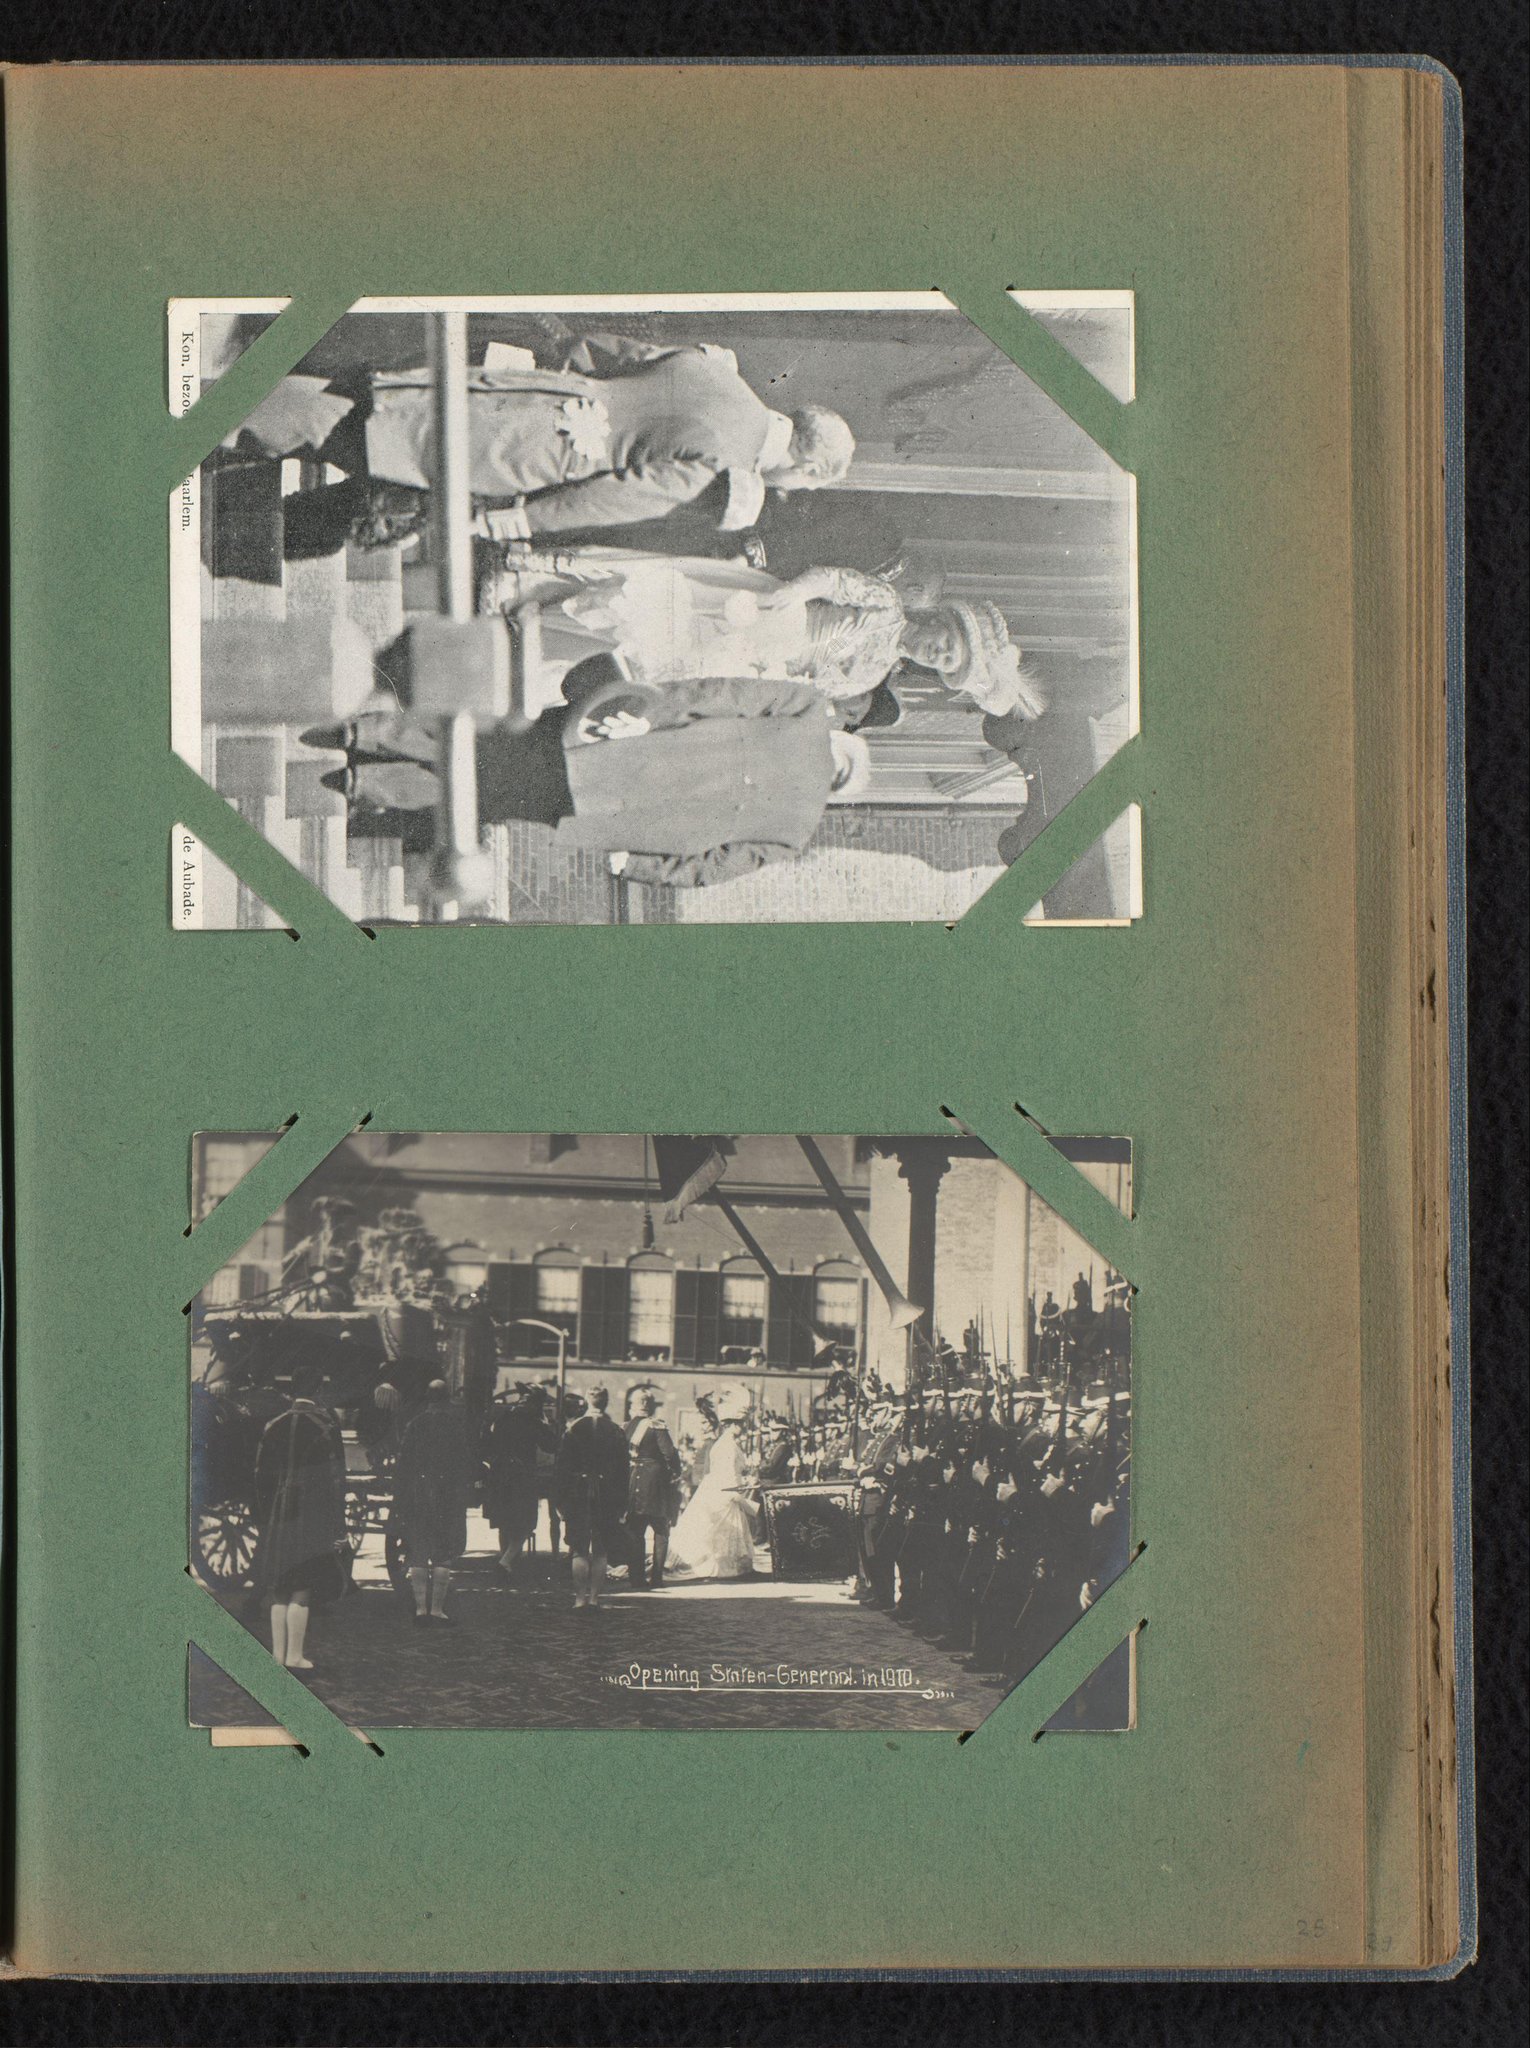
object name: photograph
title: Twee prentbriefkaarten van koningin Wilhelmina op bezoek in Haarlem en de opening van de Staten-Generaal in 1910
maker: Anonymous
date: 1909-1910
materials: paper, cardboard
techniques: gelatin silver print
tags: the hague, print maker, wilhelmina of the netherlands, queen, haarlem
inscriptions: inscription: ‘Kon. bezoek in Haarlem. Bij de Aubade.’, inscription: ‘Opening Staten-Generaal in 1910.’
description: Deze foto en prent maken deel uit van een album.